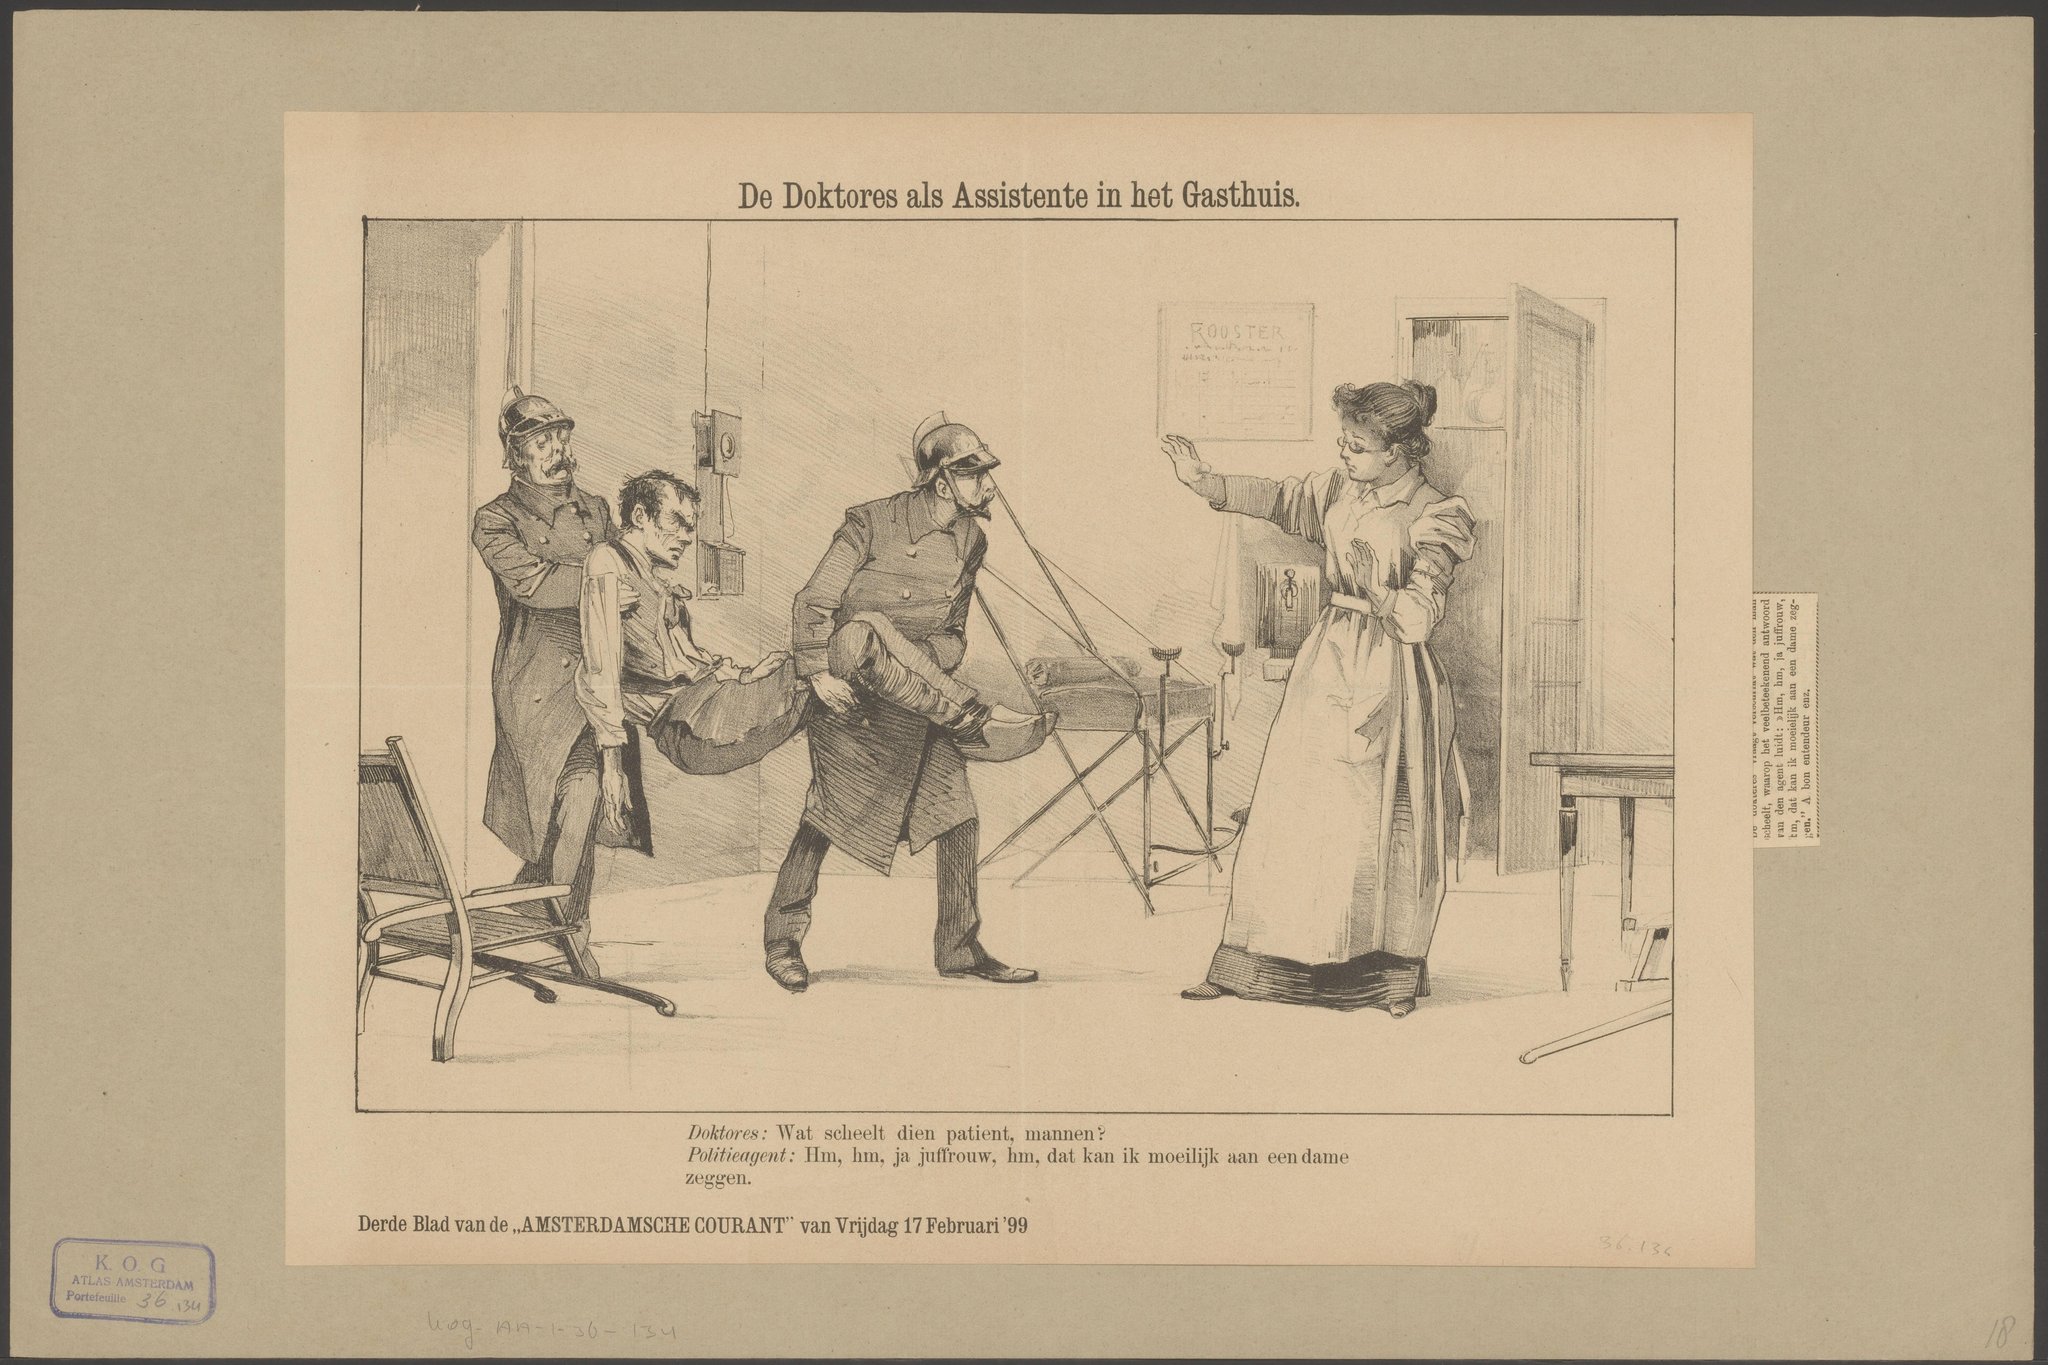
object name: print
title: Vrouwelijke arts schrikt als de politie een man binnendraagt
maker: Anonymous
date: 1899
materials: paper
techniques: letterpress printing, lithograph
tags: hospital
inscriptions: collector's mark: Lugt 1641b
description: Vrouwelijke arts schrikt als de politie een man binnendraagt. In de inscriptie geeft de agent aan dat hij niet aan een dame kan vertellen wat er aan de hand is met de man. Onderwerpsrubriek binnen de Atlas Amsterdam: Armwezen en liefdadige instellingen: I. Stadsinrichtingen: Binnengasthuis.